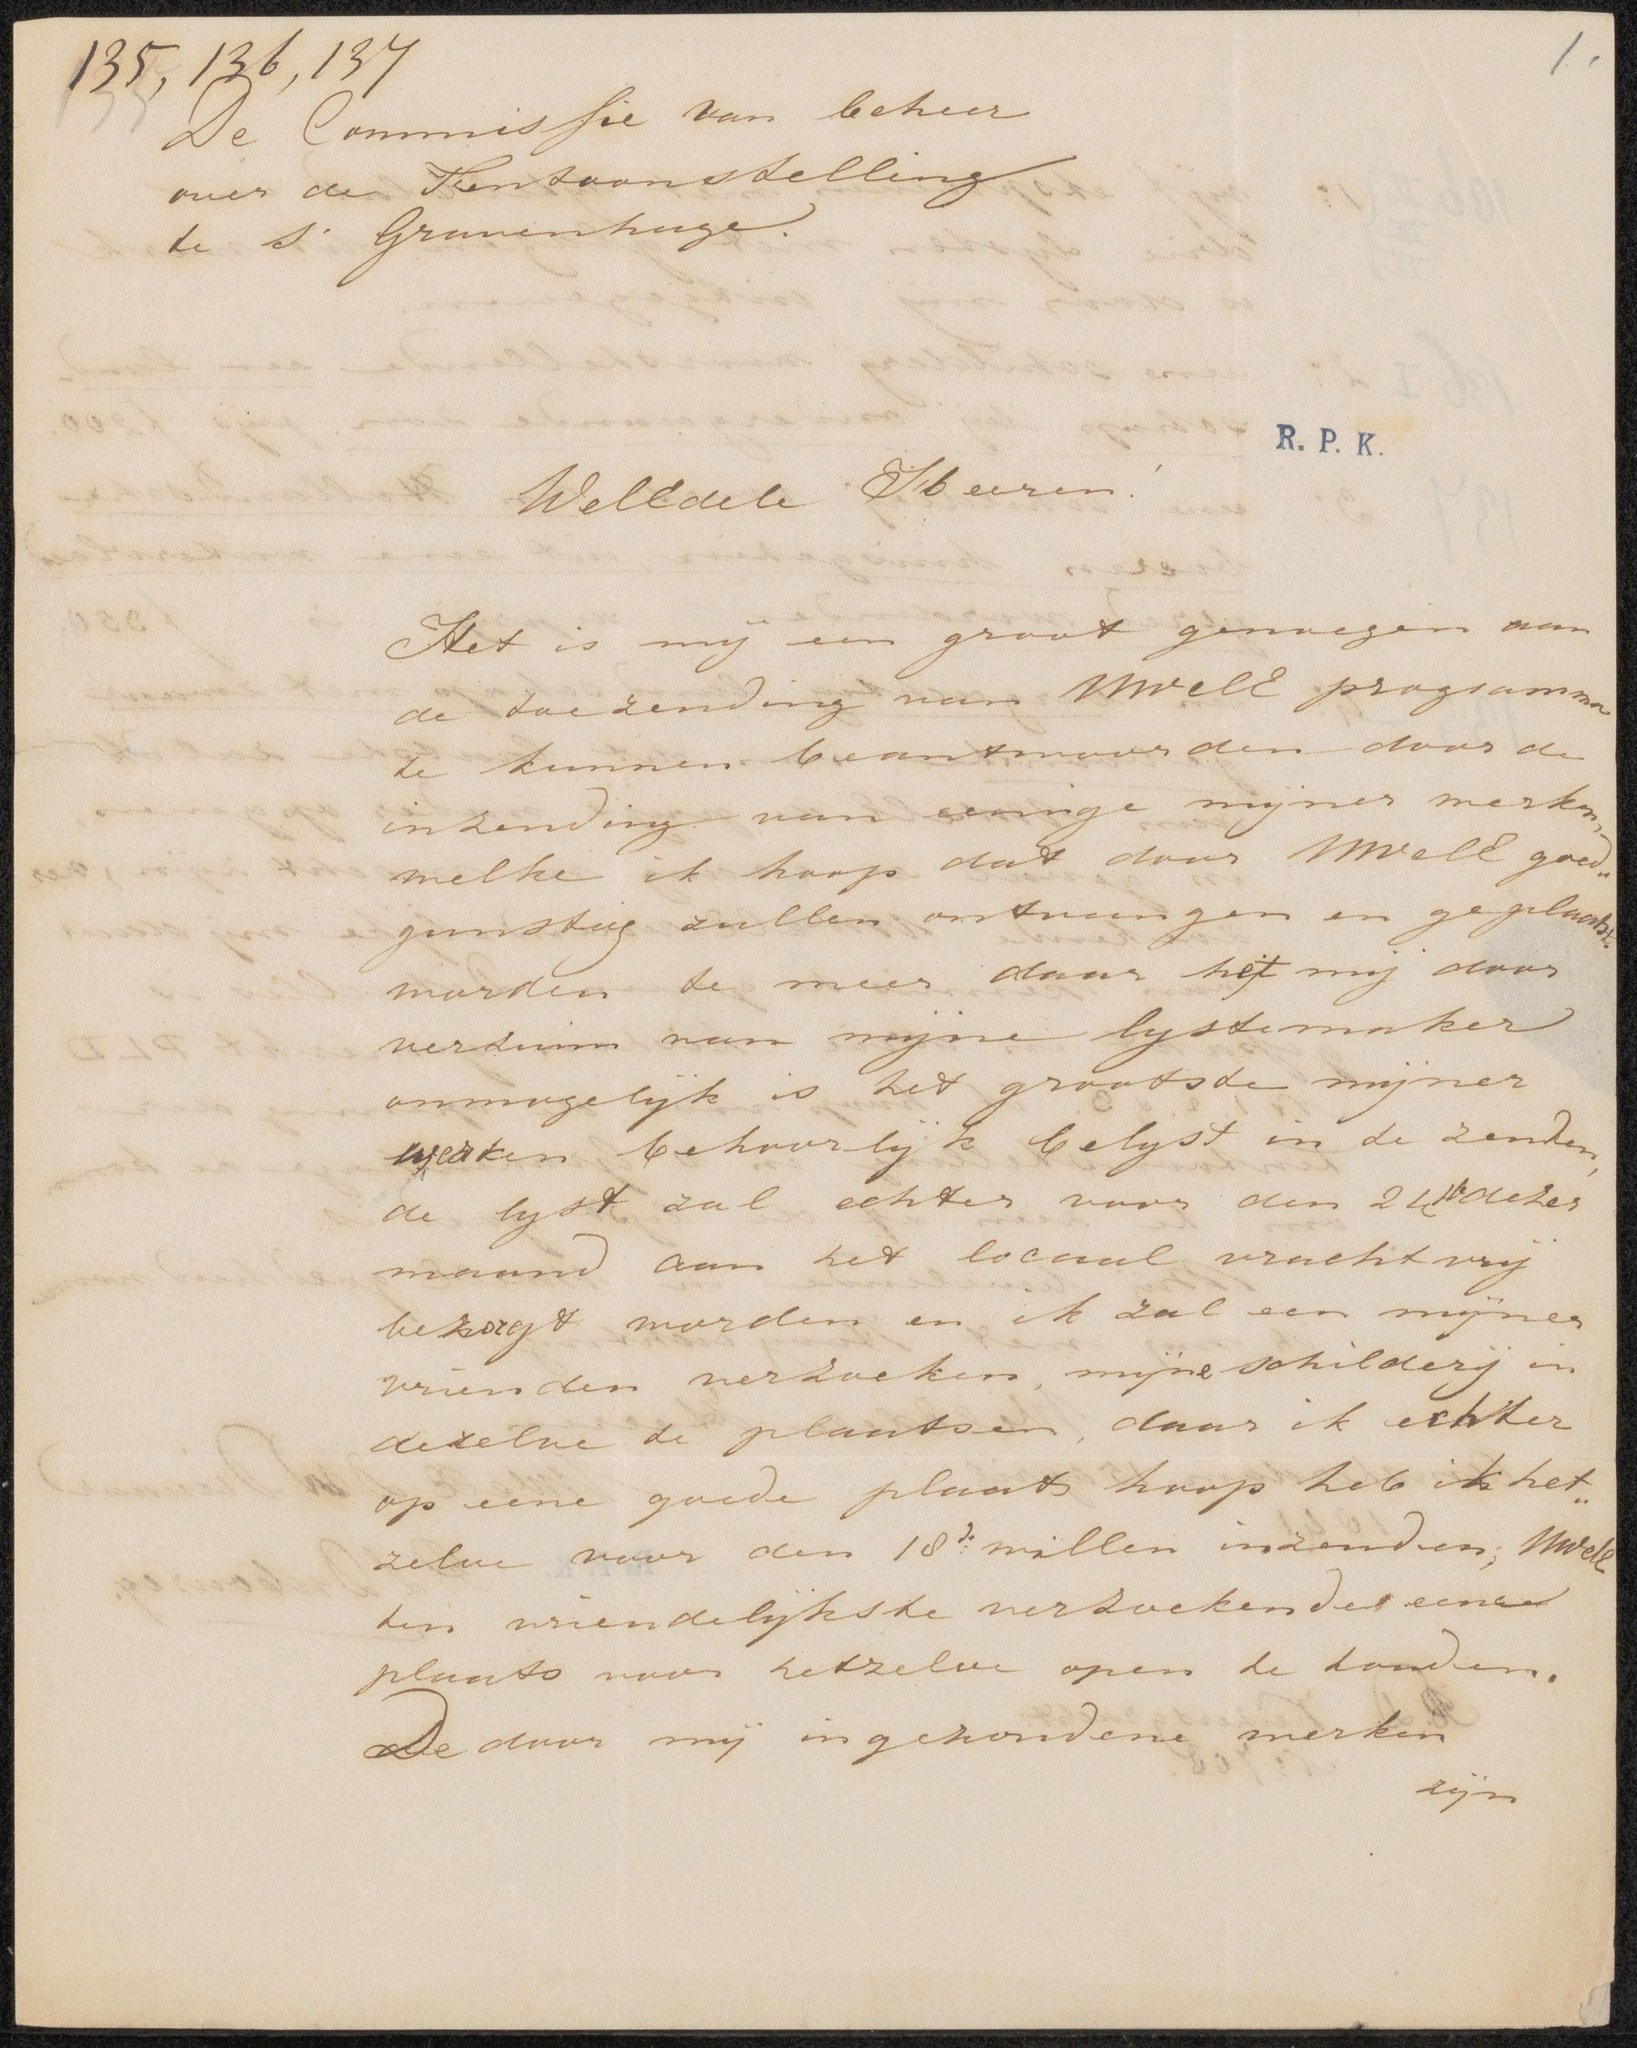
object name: letter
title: Brief aan de commissie van de Tentoonstelling van Levende Meesters in Den Haag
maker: pierre louis dubourcq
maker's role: draughtsman, painter, print maker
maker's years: 1815-1873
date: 1841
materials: ink, paper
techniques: pen, writing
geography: amsterdam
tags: the graphic arts, painting (including book-illumination, miniature-painting), exhibition ~ art, money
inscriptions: collector's mark: Lugt 2233